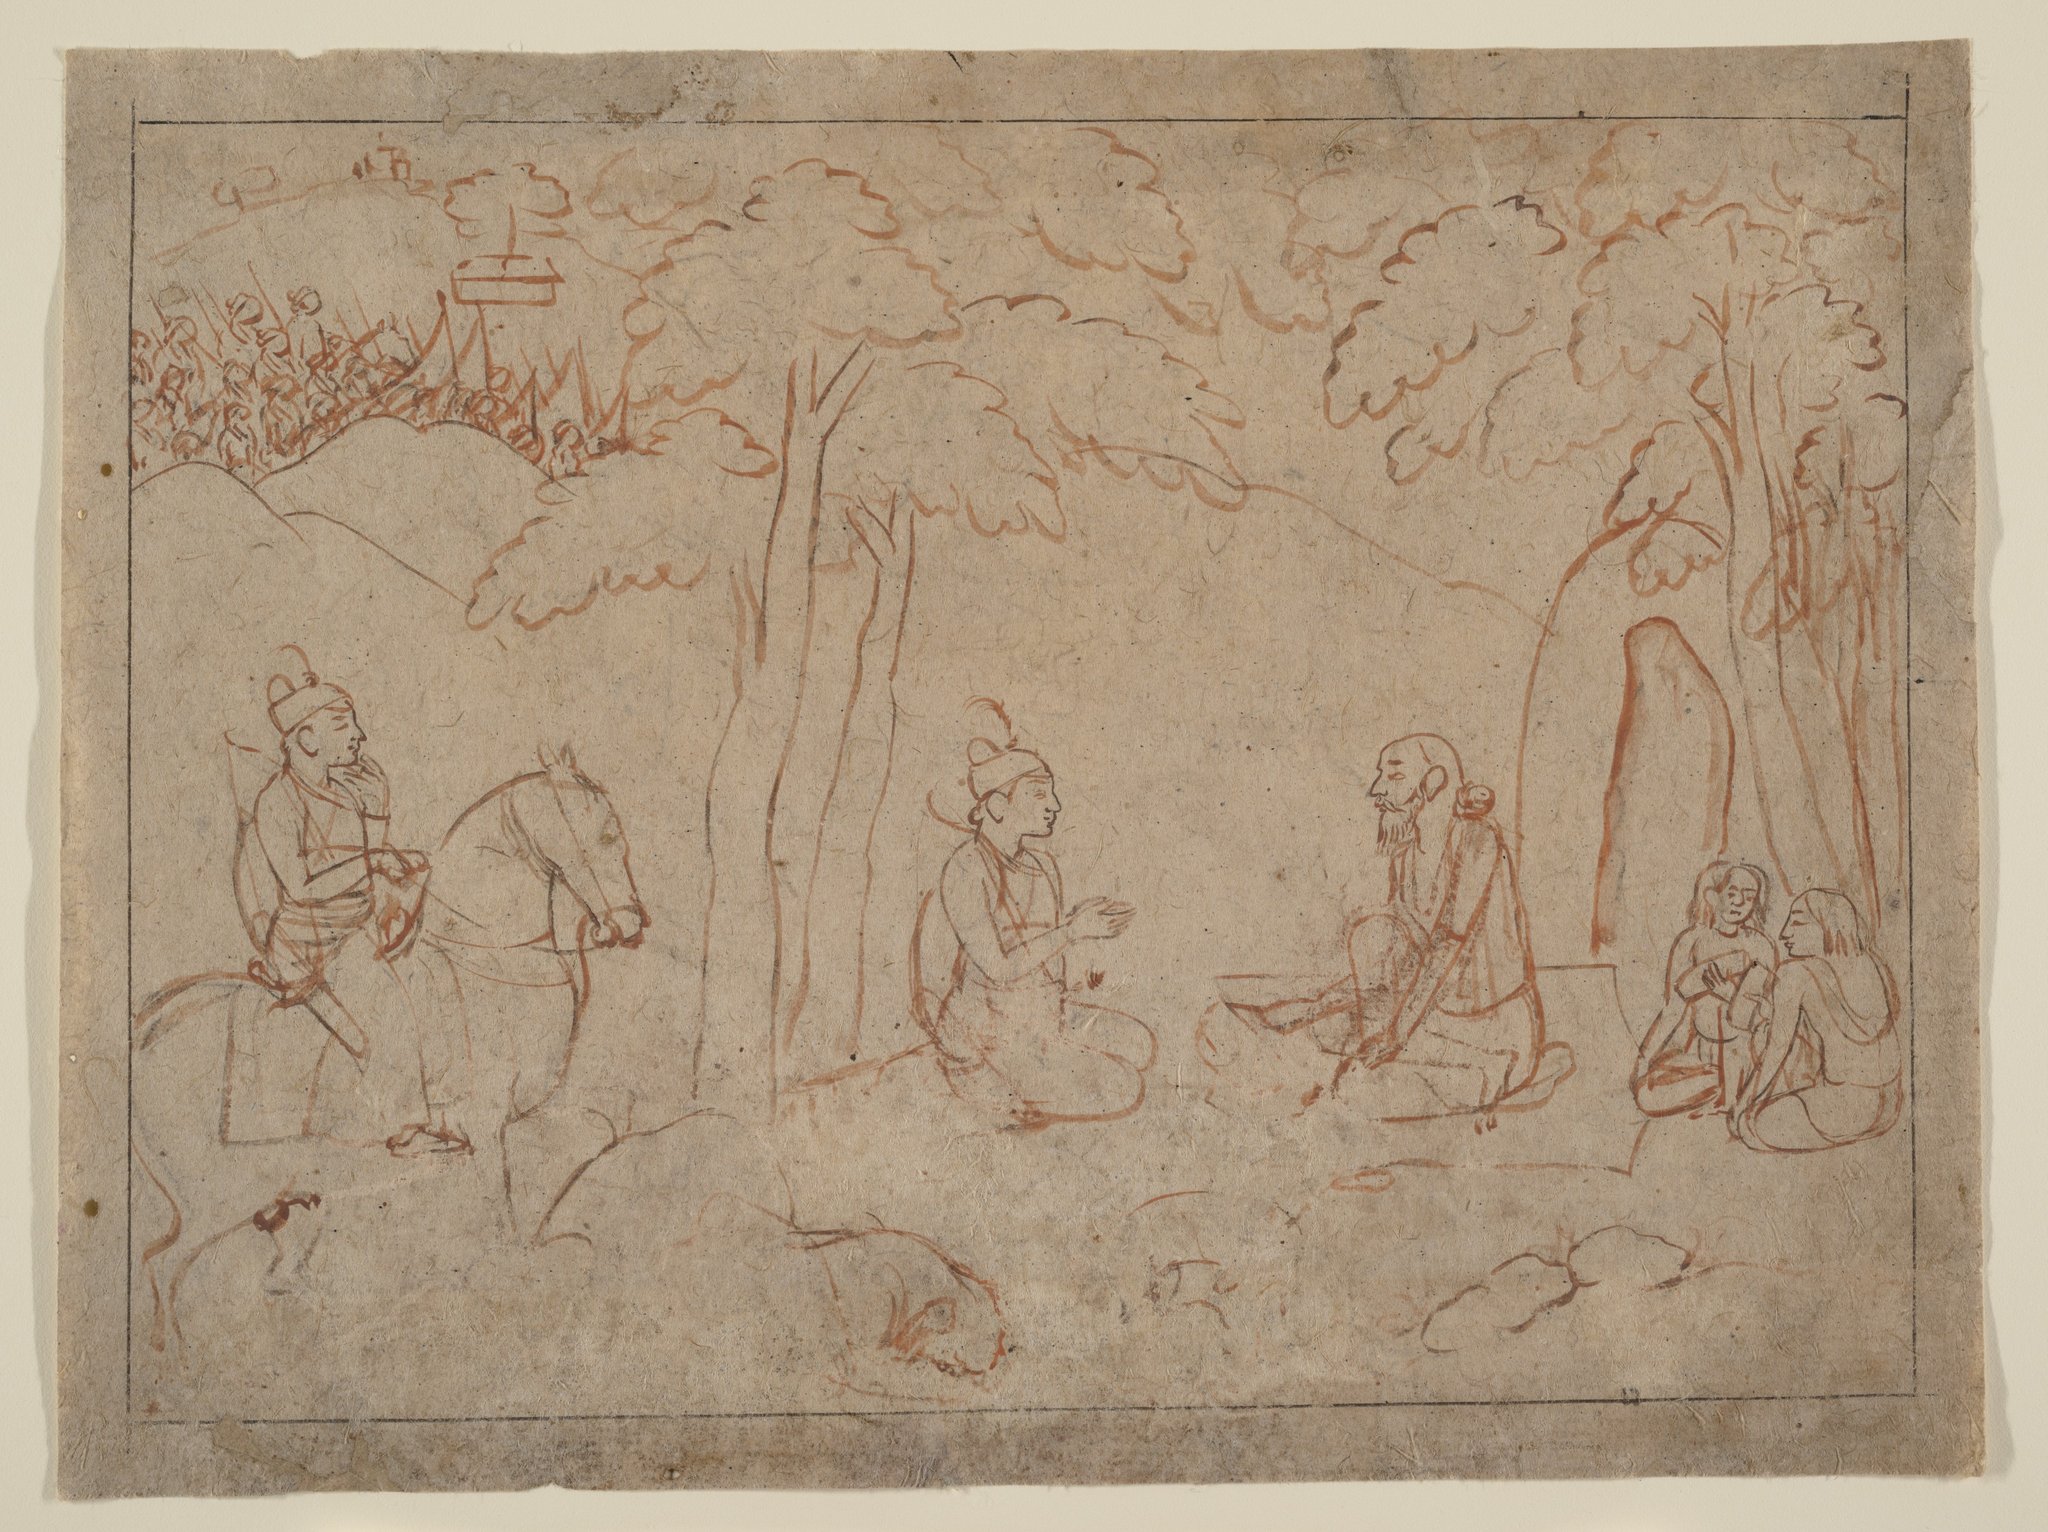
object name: drawing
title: Rama and Lakshmana Visit the Hermitage of an Ascetic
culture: indian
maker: nainsukh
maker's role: artist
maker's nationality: indian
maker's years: 1725-1778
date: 1775-1780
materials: paper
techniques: wash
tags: men,horses